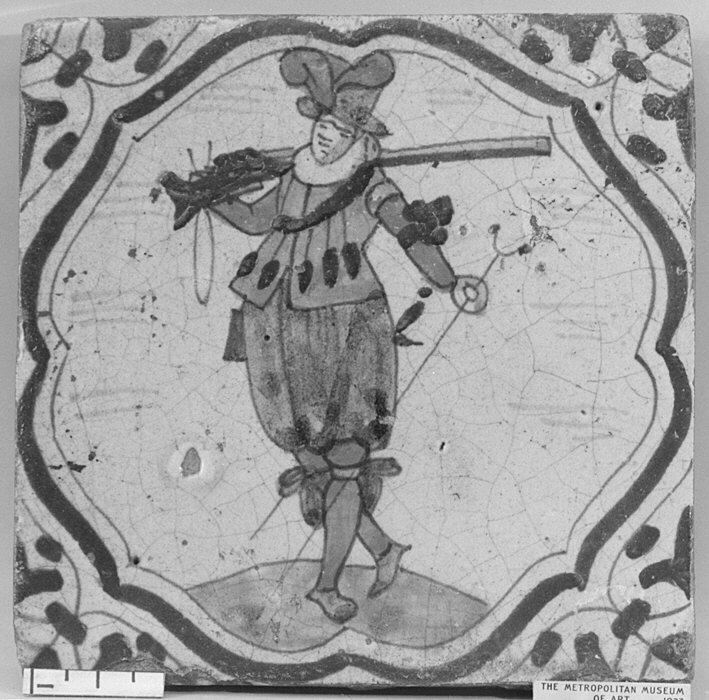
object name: tile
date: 1620-1640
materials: earthenware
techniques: glazing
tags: firearms,men